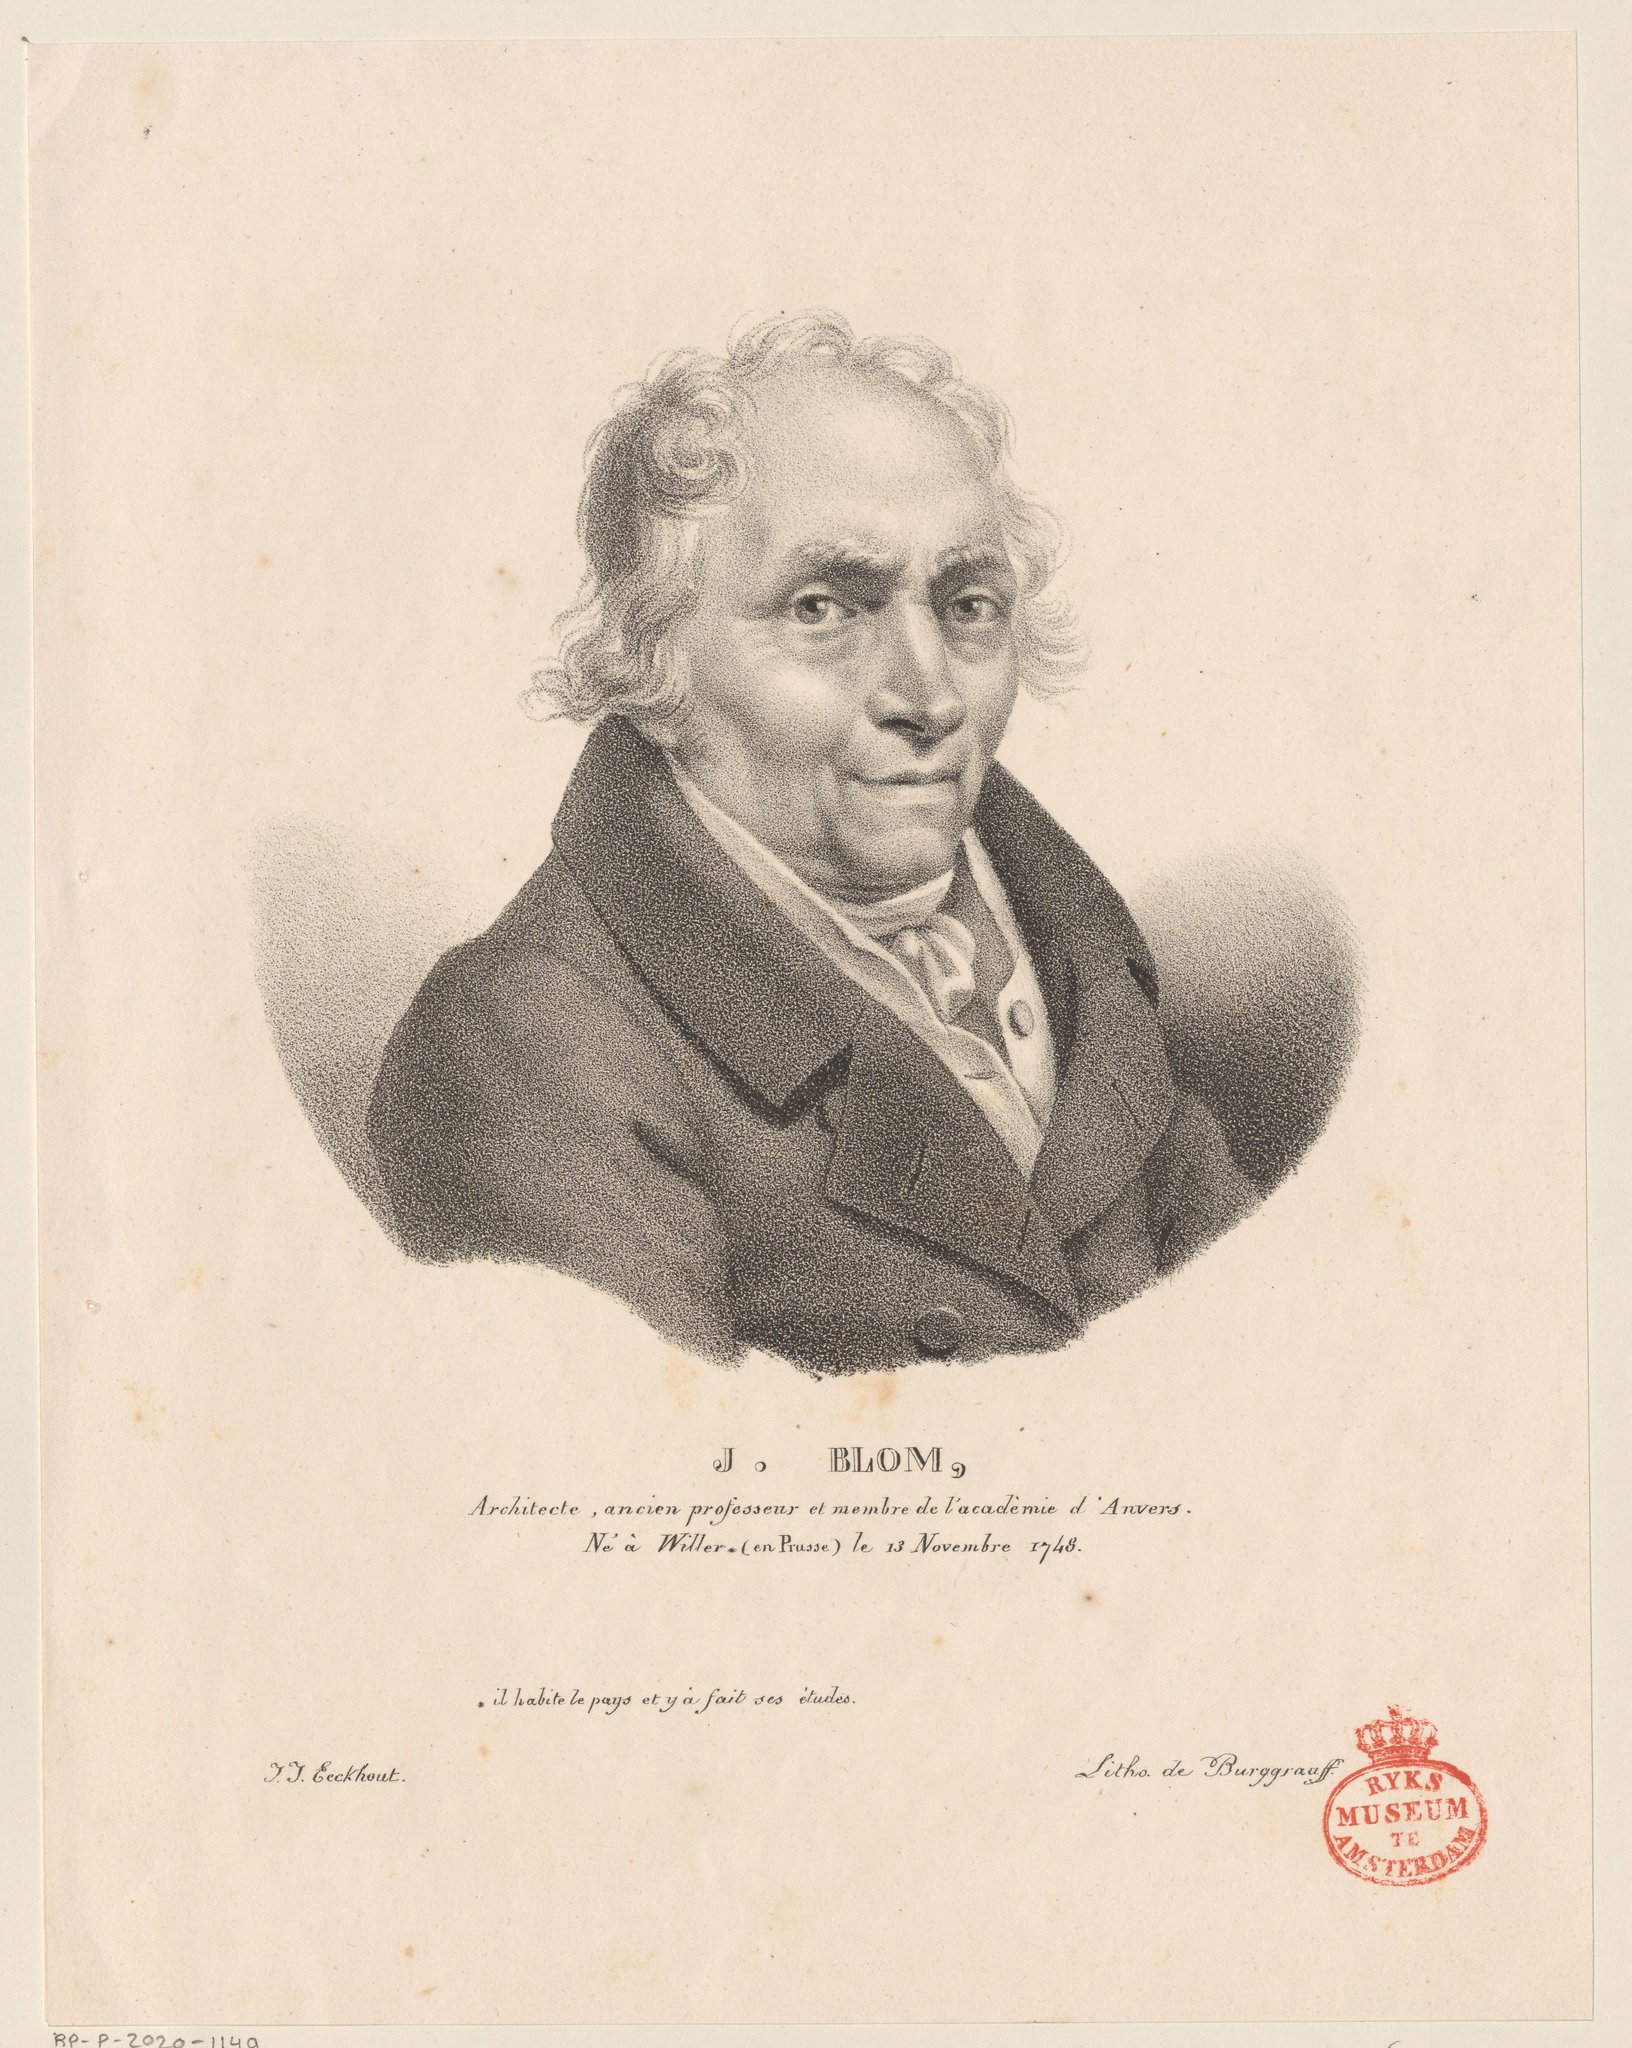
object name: print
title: Portretten van hedendaagse kunstenaars uit het Verenigd Koninkrijk der Nederlanden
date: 1822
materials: paper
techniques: lithograph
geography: brussels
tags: antwerp, historical persons, portrait, self-portrait of architect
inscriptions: collector's mark: Lugt 12